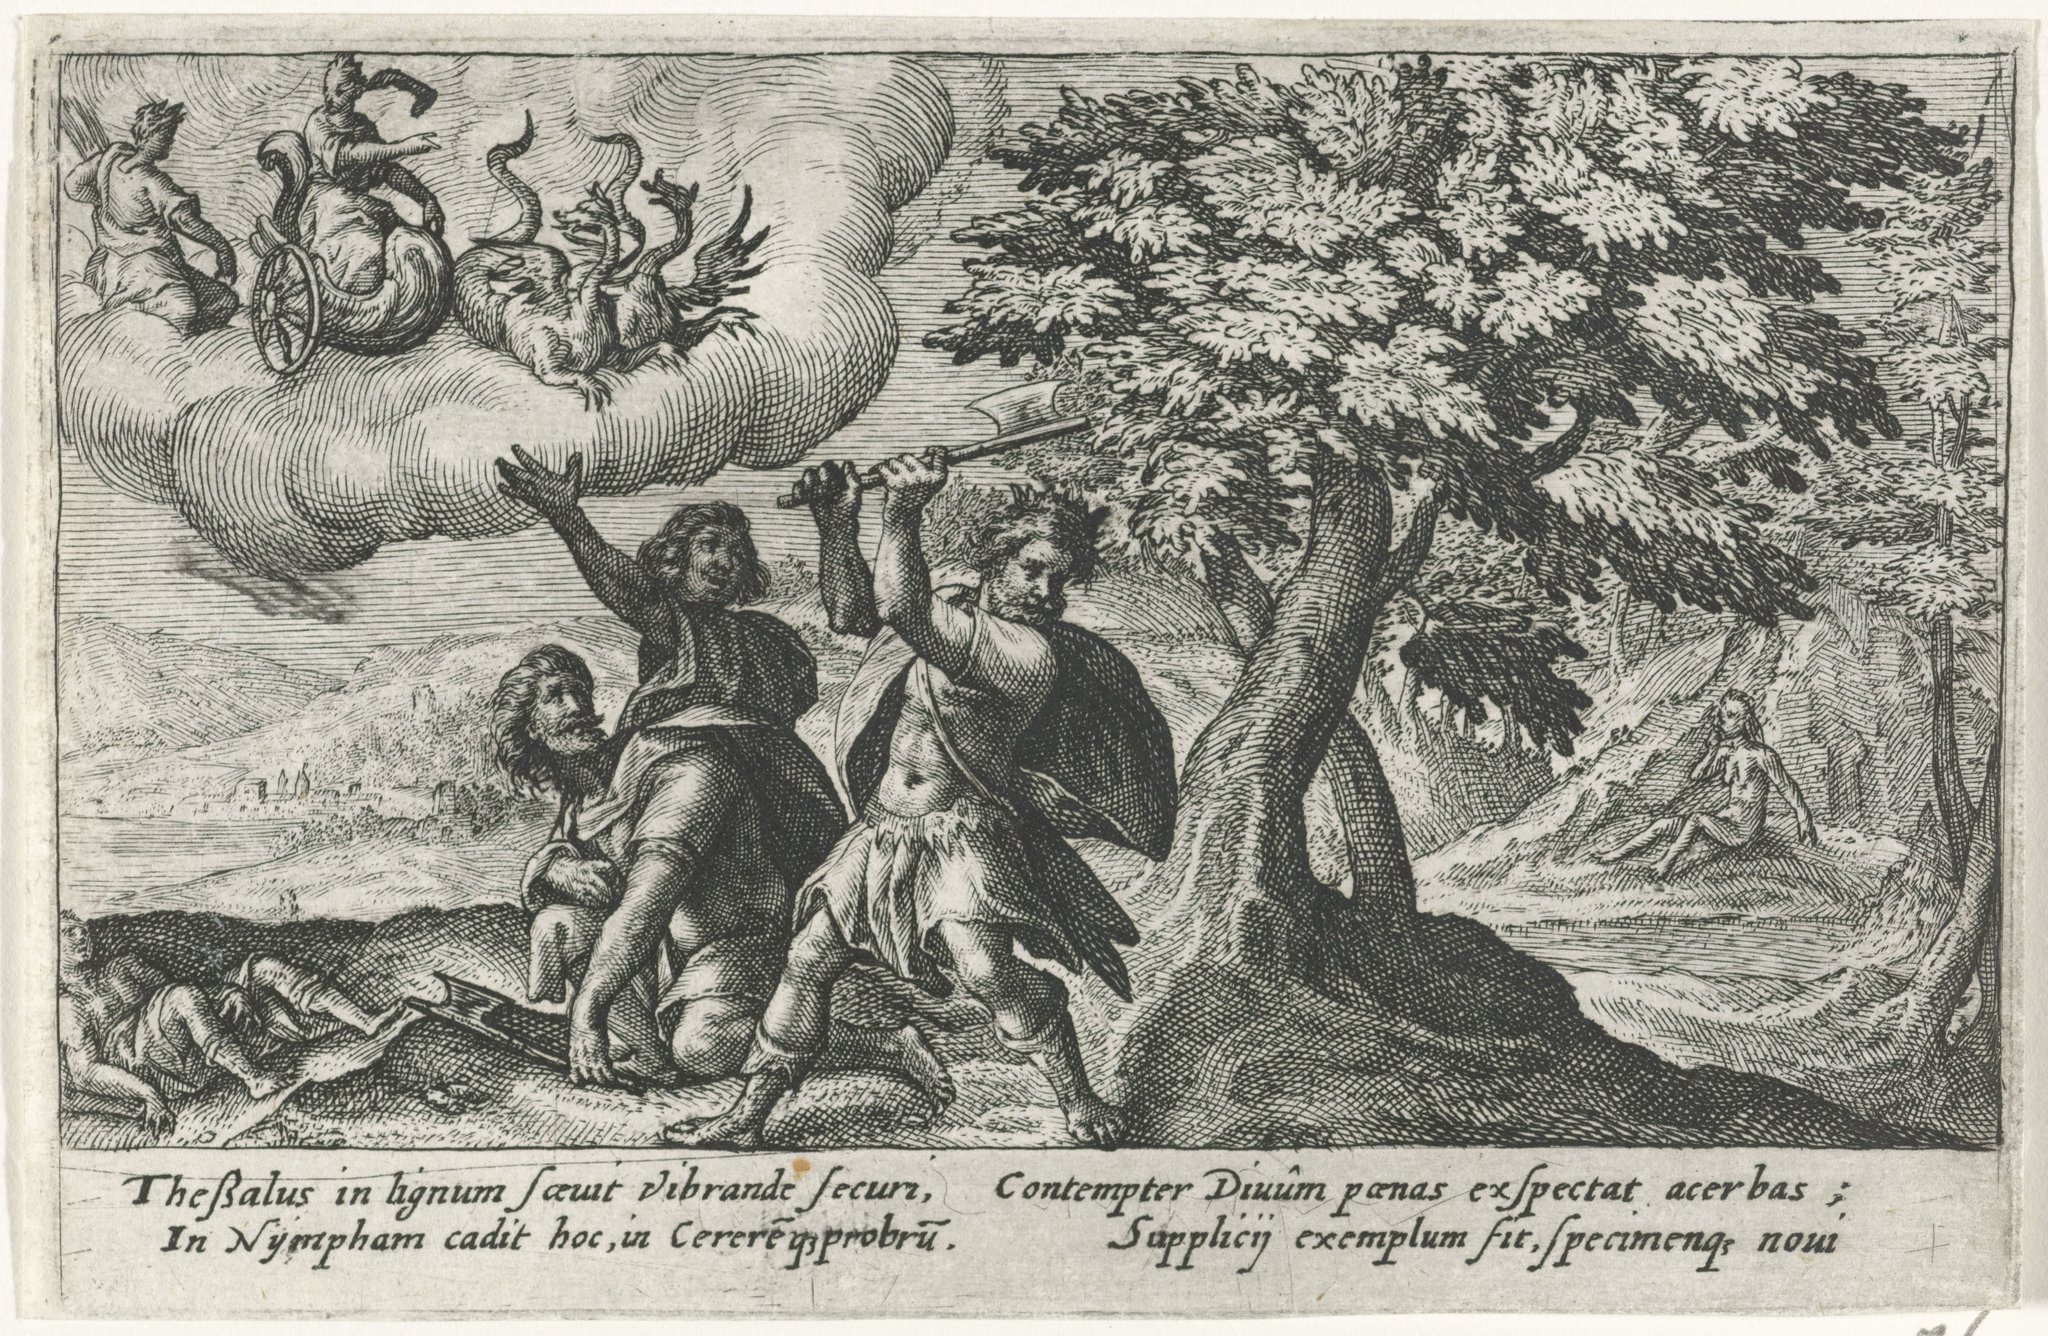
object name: print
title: Metamorfosen van Ovidius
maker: crispijn van de passe (i)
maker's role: draughtsman, print maker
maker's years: 1564-1637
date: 1602-1607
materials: paper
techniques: engraving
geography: cologne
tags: a nymph is sent to fames in ceres' chariot, in order to punish erysichthon, erysichthon fells an oak consecrated to ceres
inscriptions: collector's mark: Lugt 2228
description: Erysichthon hakt de boom van Ceres om. Als wraak stuurt Ceres een nimf met haar drakenwagen naar Scythië om de Honger te vragen Erysichthon te straffen. In de marge een vierregelig onderschrift, in twee kolommen, in het Latijn.